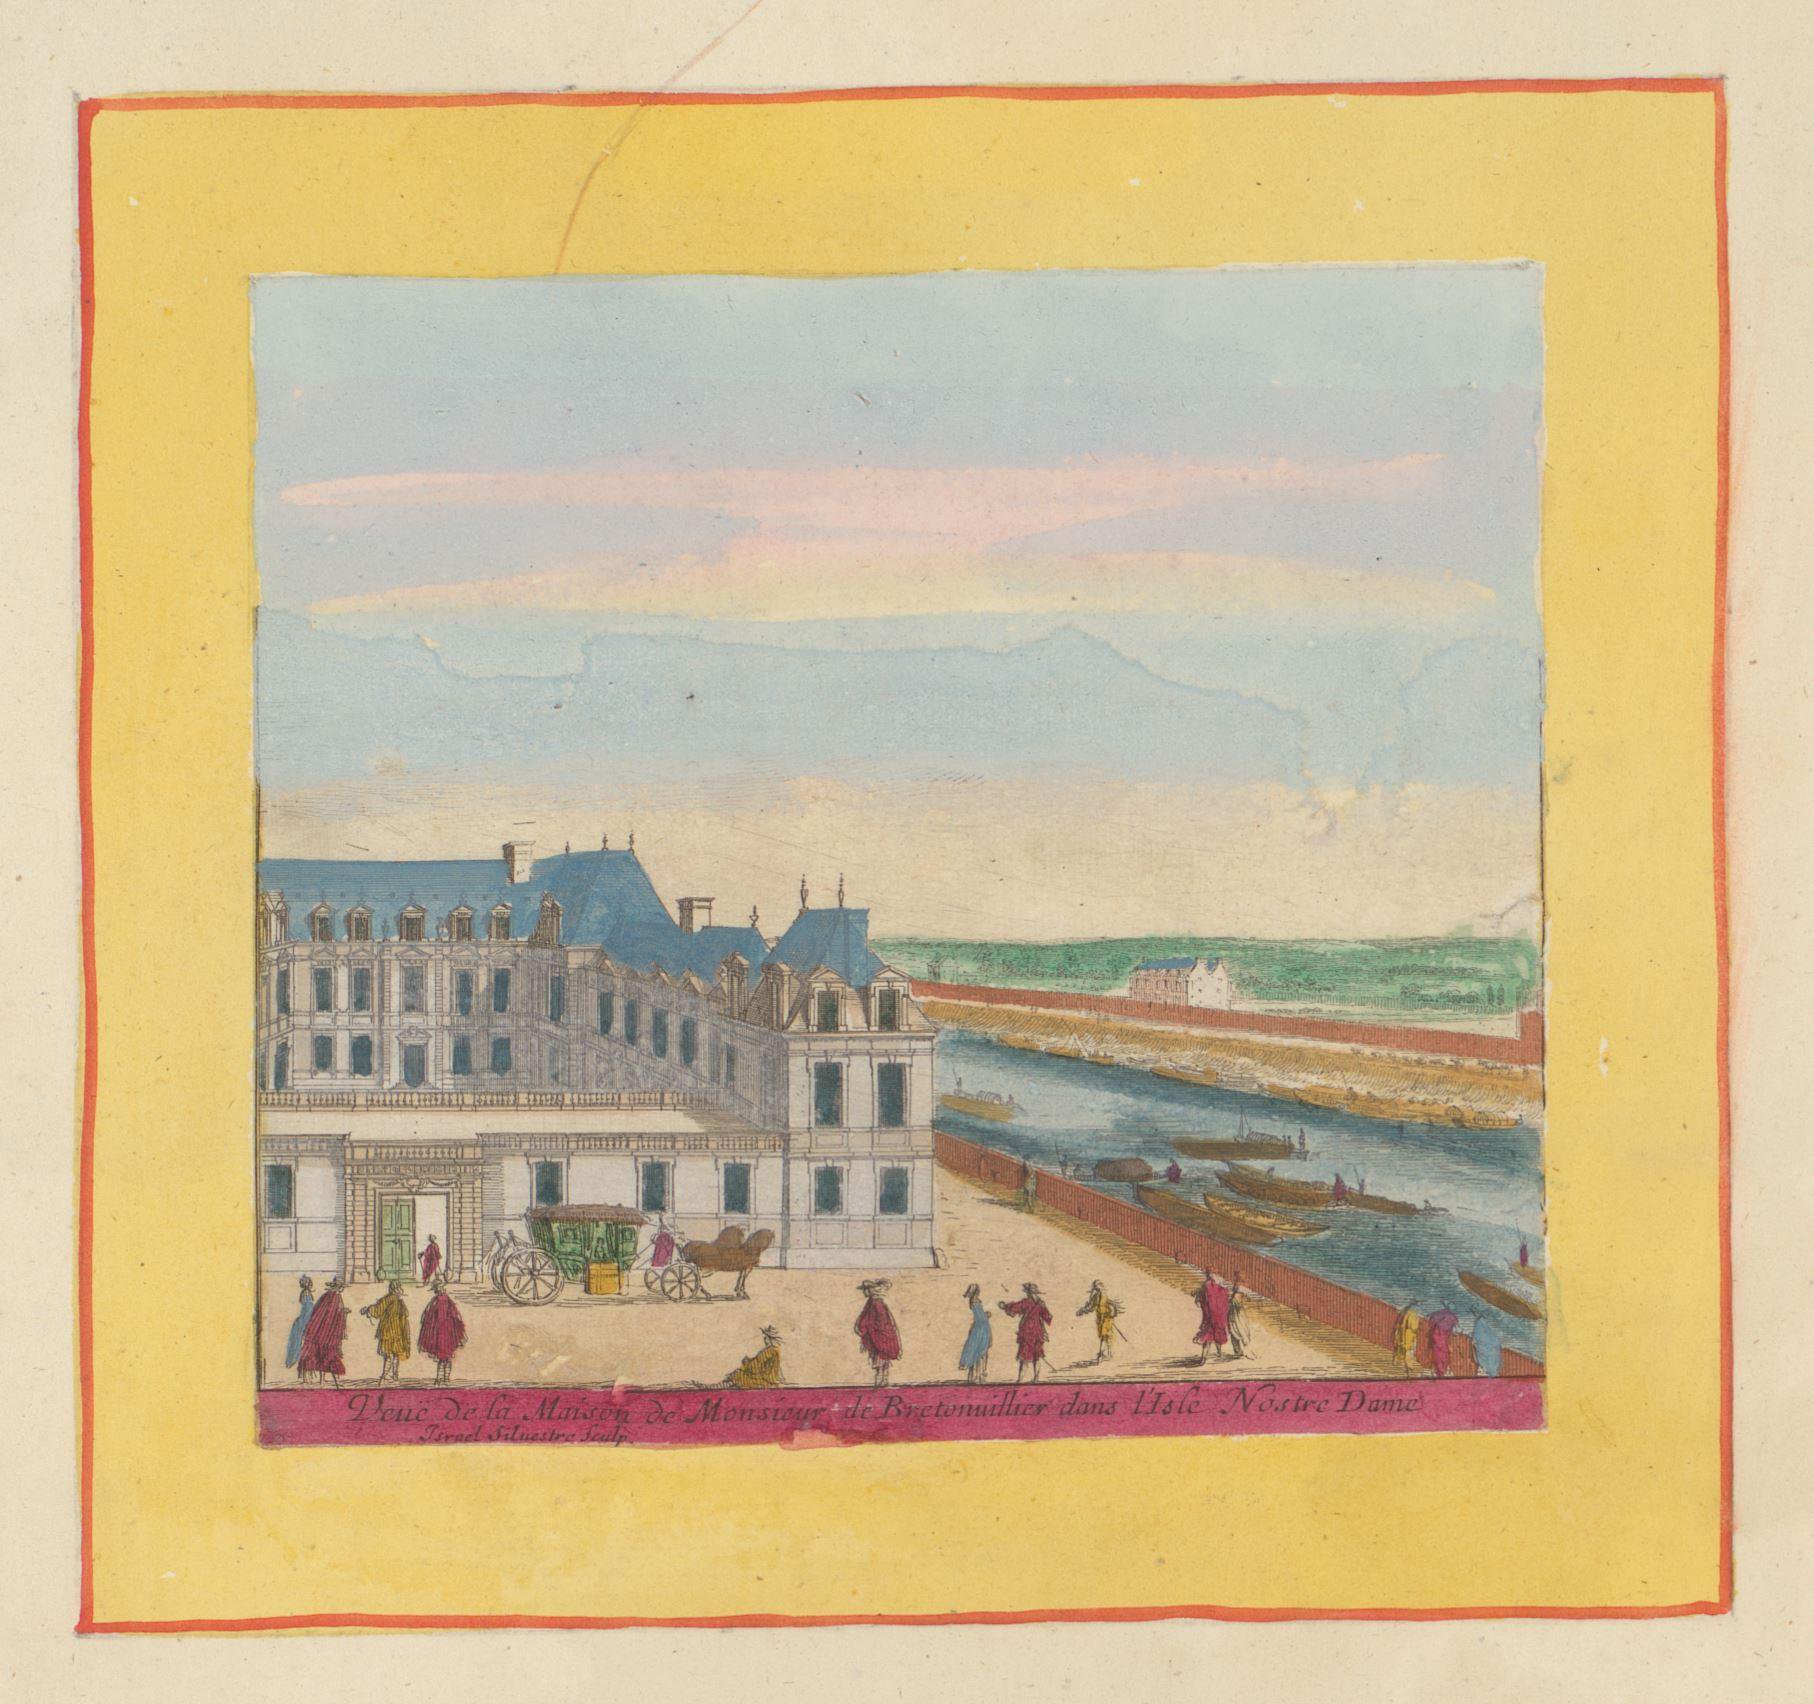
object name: album leaf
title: Veuë de la Maison de Monsieur de Bretonvillier dans l'Isle Nostre Dame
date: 1631-1691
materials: paper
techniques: etching, hand coloring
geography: the hague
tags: hôtel, i.e. small palace in city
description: Gezicht op Hôtel de Bretonvilliers te Parijs. Rechts de rivier de Seine. Prent maakt deel uit van een album.